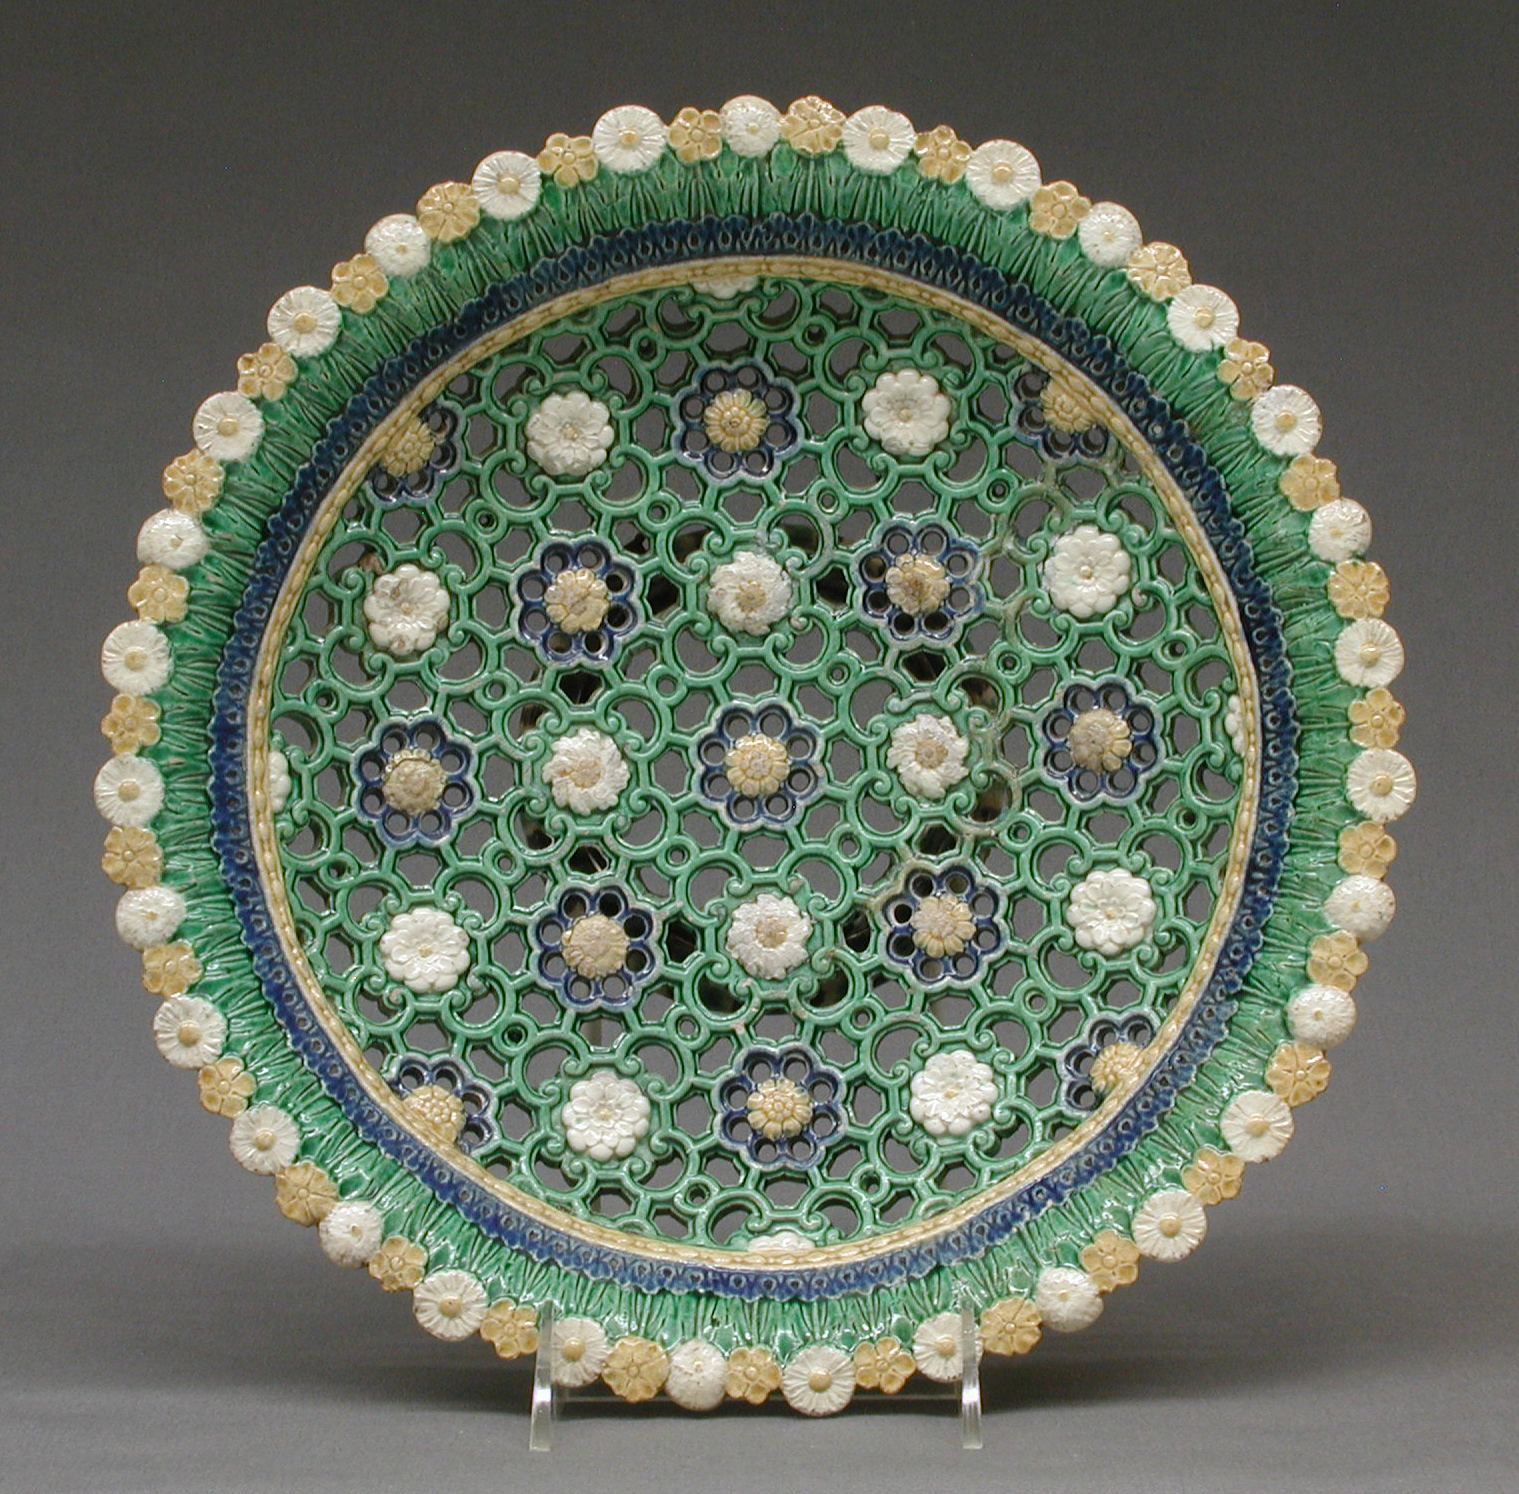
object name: dish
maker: bernard palissy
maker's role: maker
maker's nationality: french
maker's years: 1510-1590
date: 1567-1633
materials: earthenware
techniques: glazing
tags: flowers